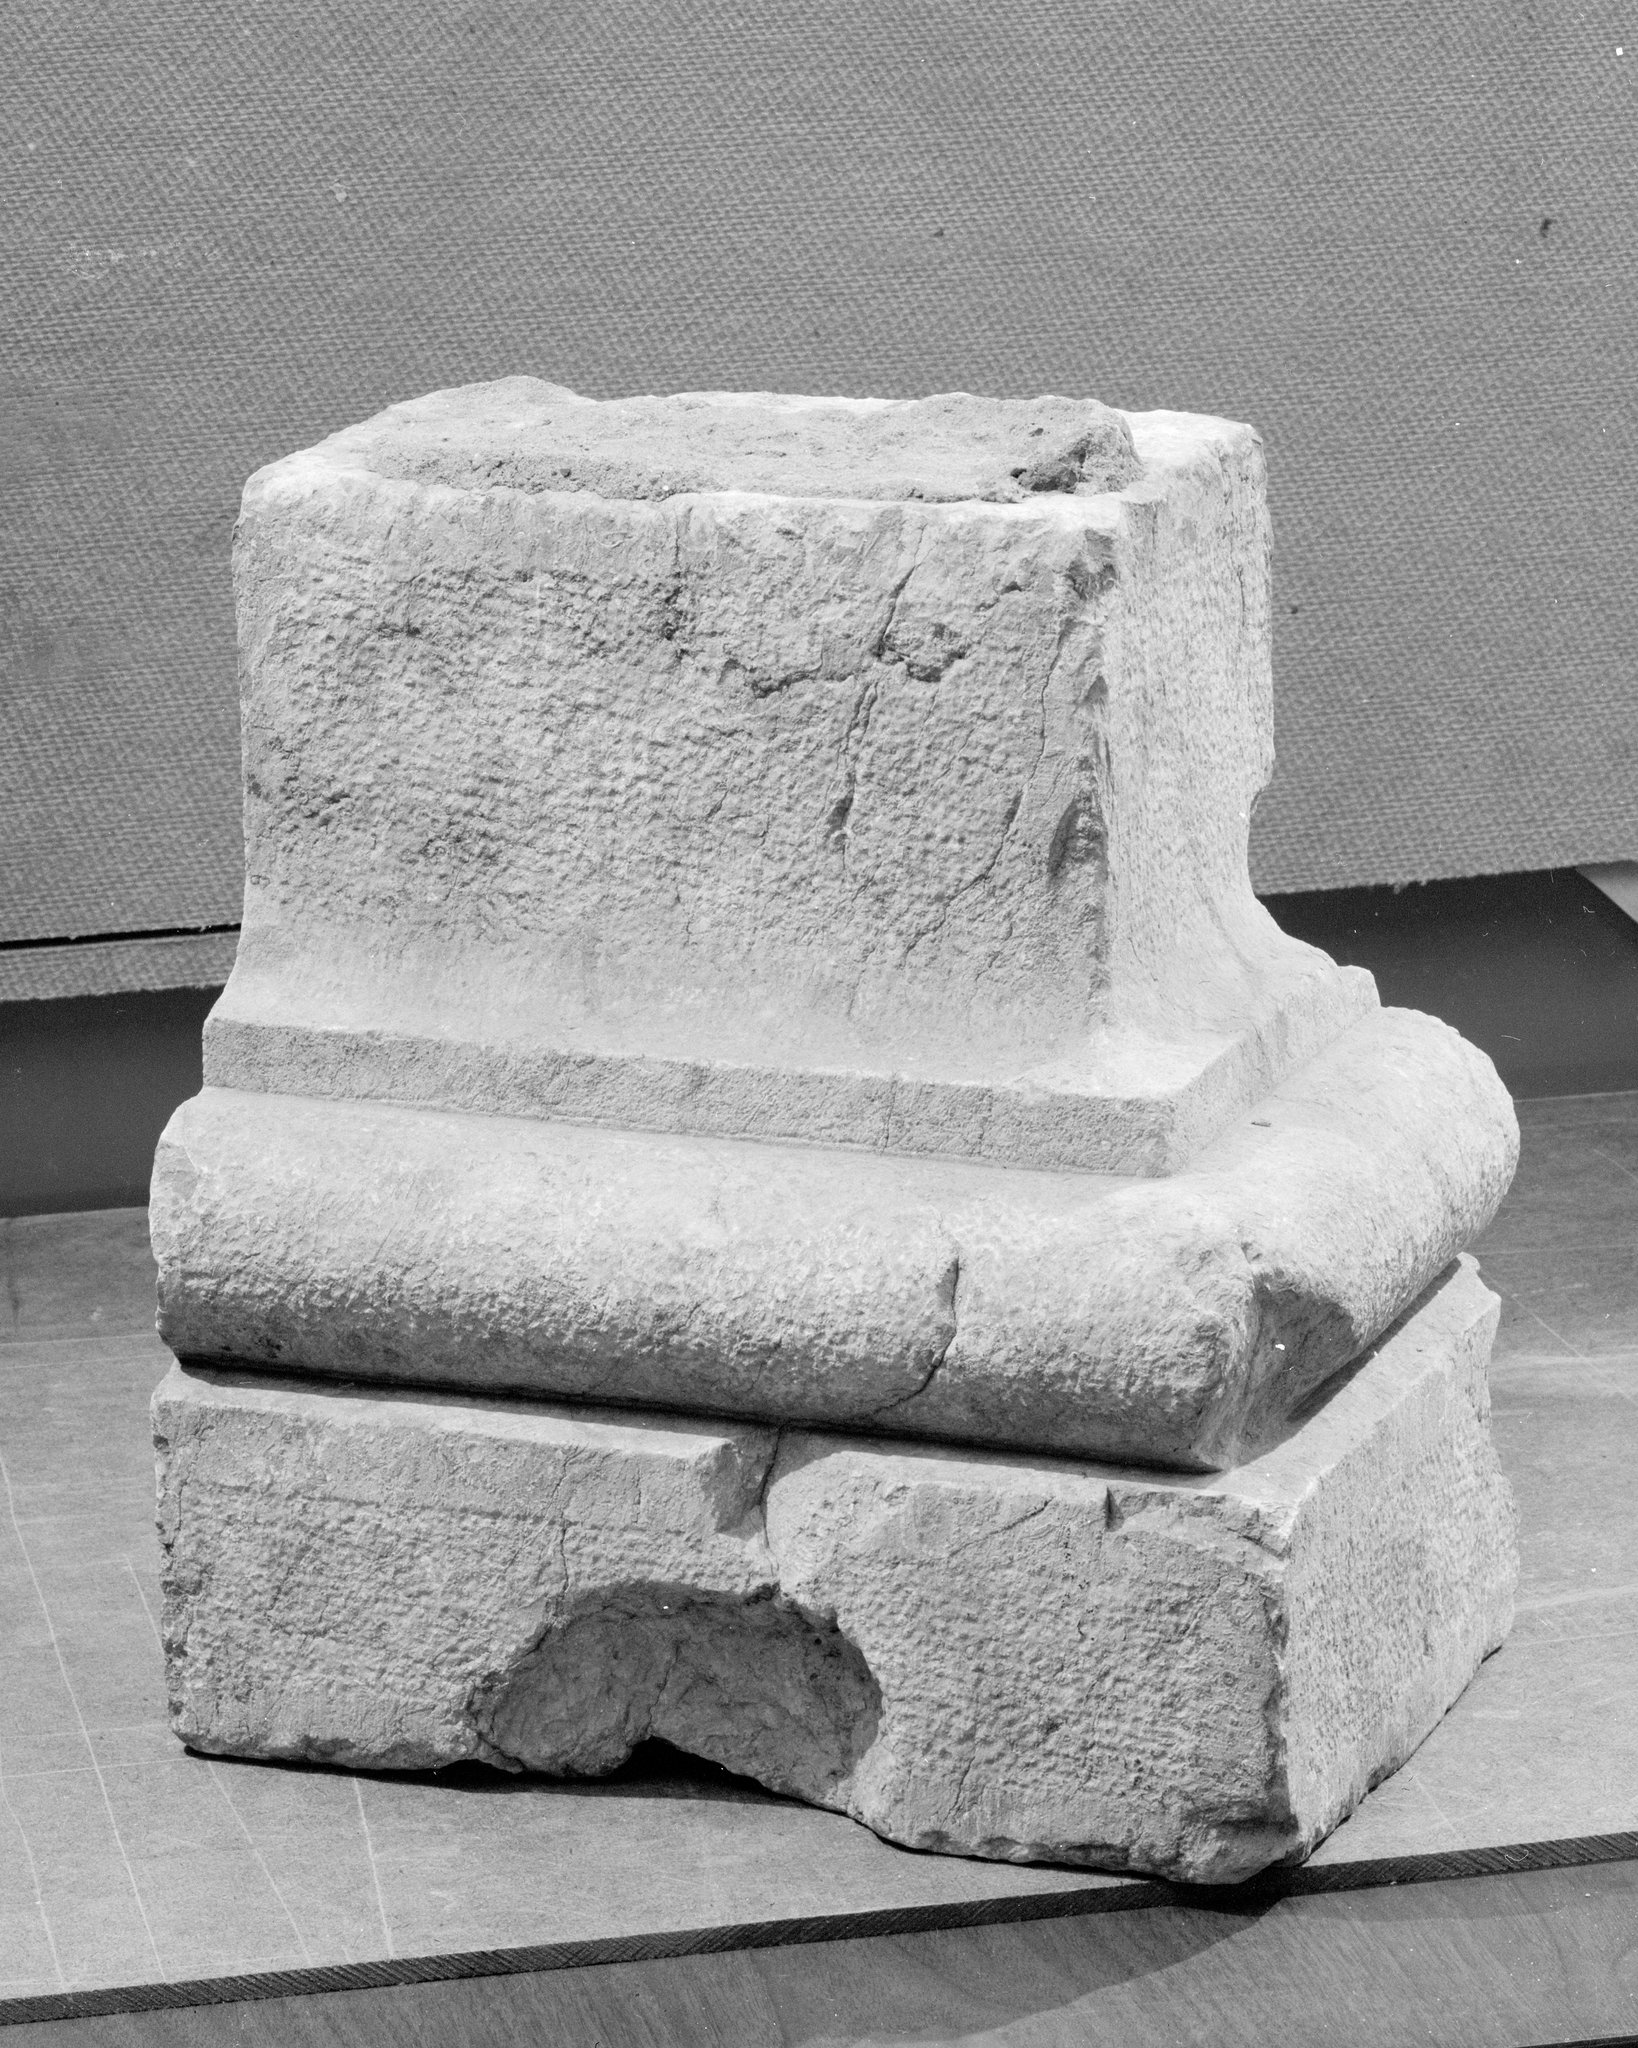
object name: base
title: Pier Base Section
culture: french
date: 1130-1140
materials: stone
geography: france